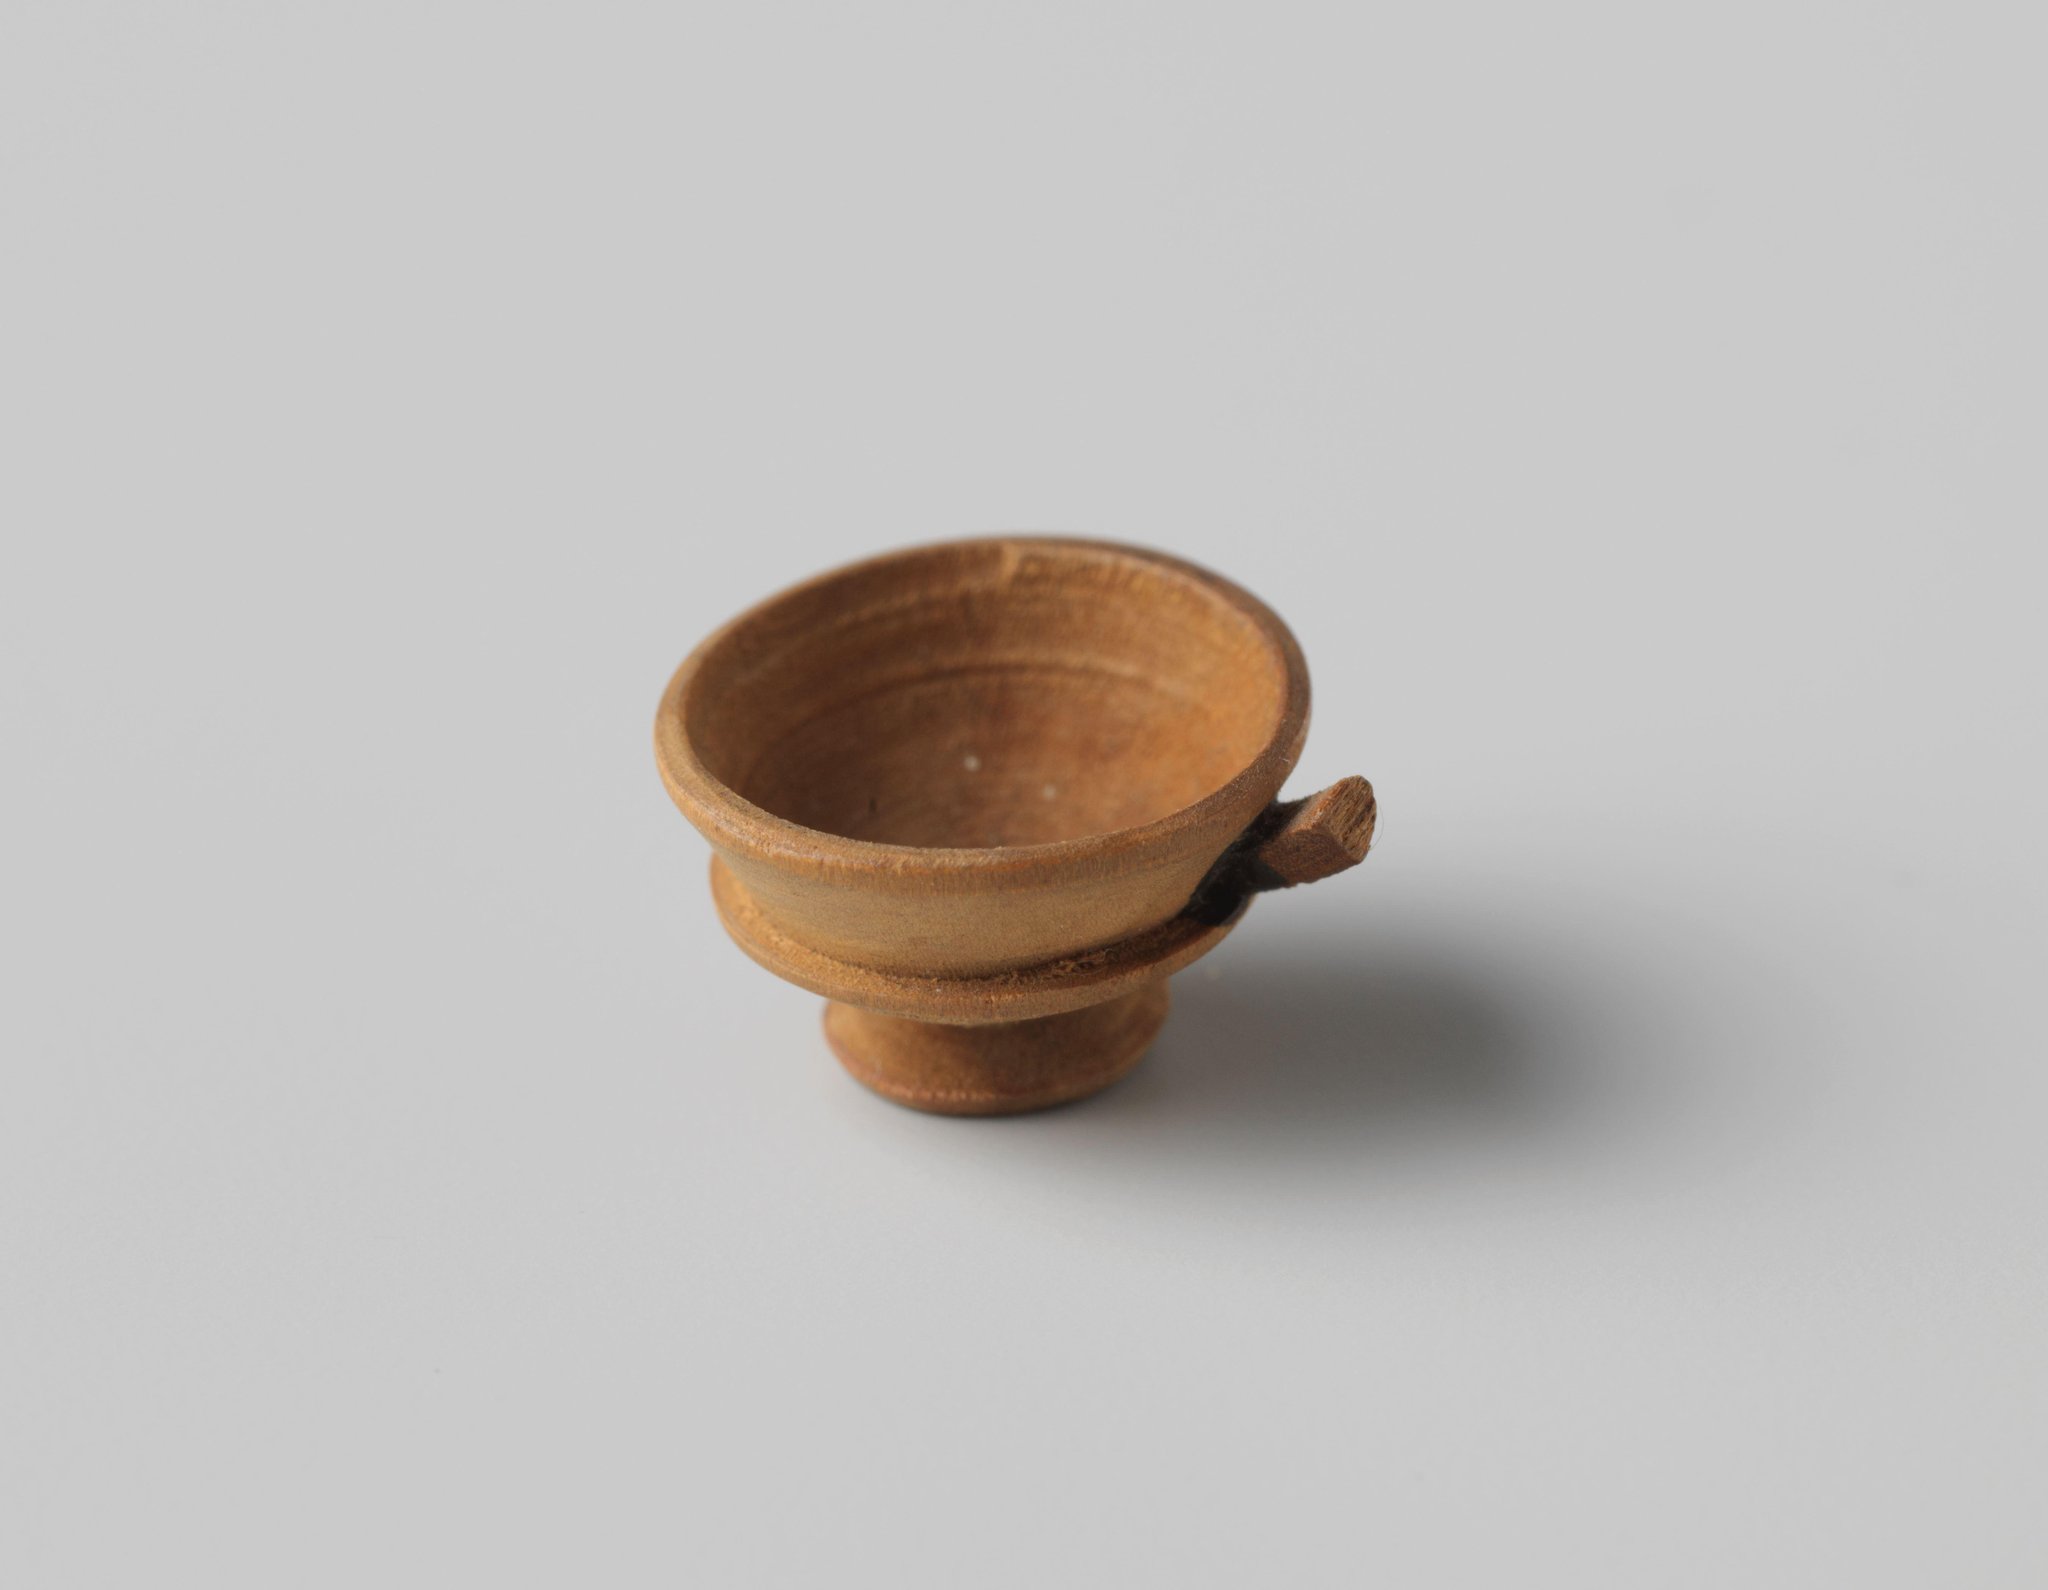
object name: bowl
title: Steelkom op voet van gedraaid hout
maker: Anonymous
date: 1675-1700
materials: wood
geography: amsterdam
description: Steelkom met korte steel op voet, gedraaid van esdoornhout.